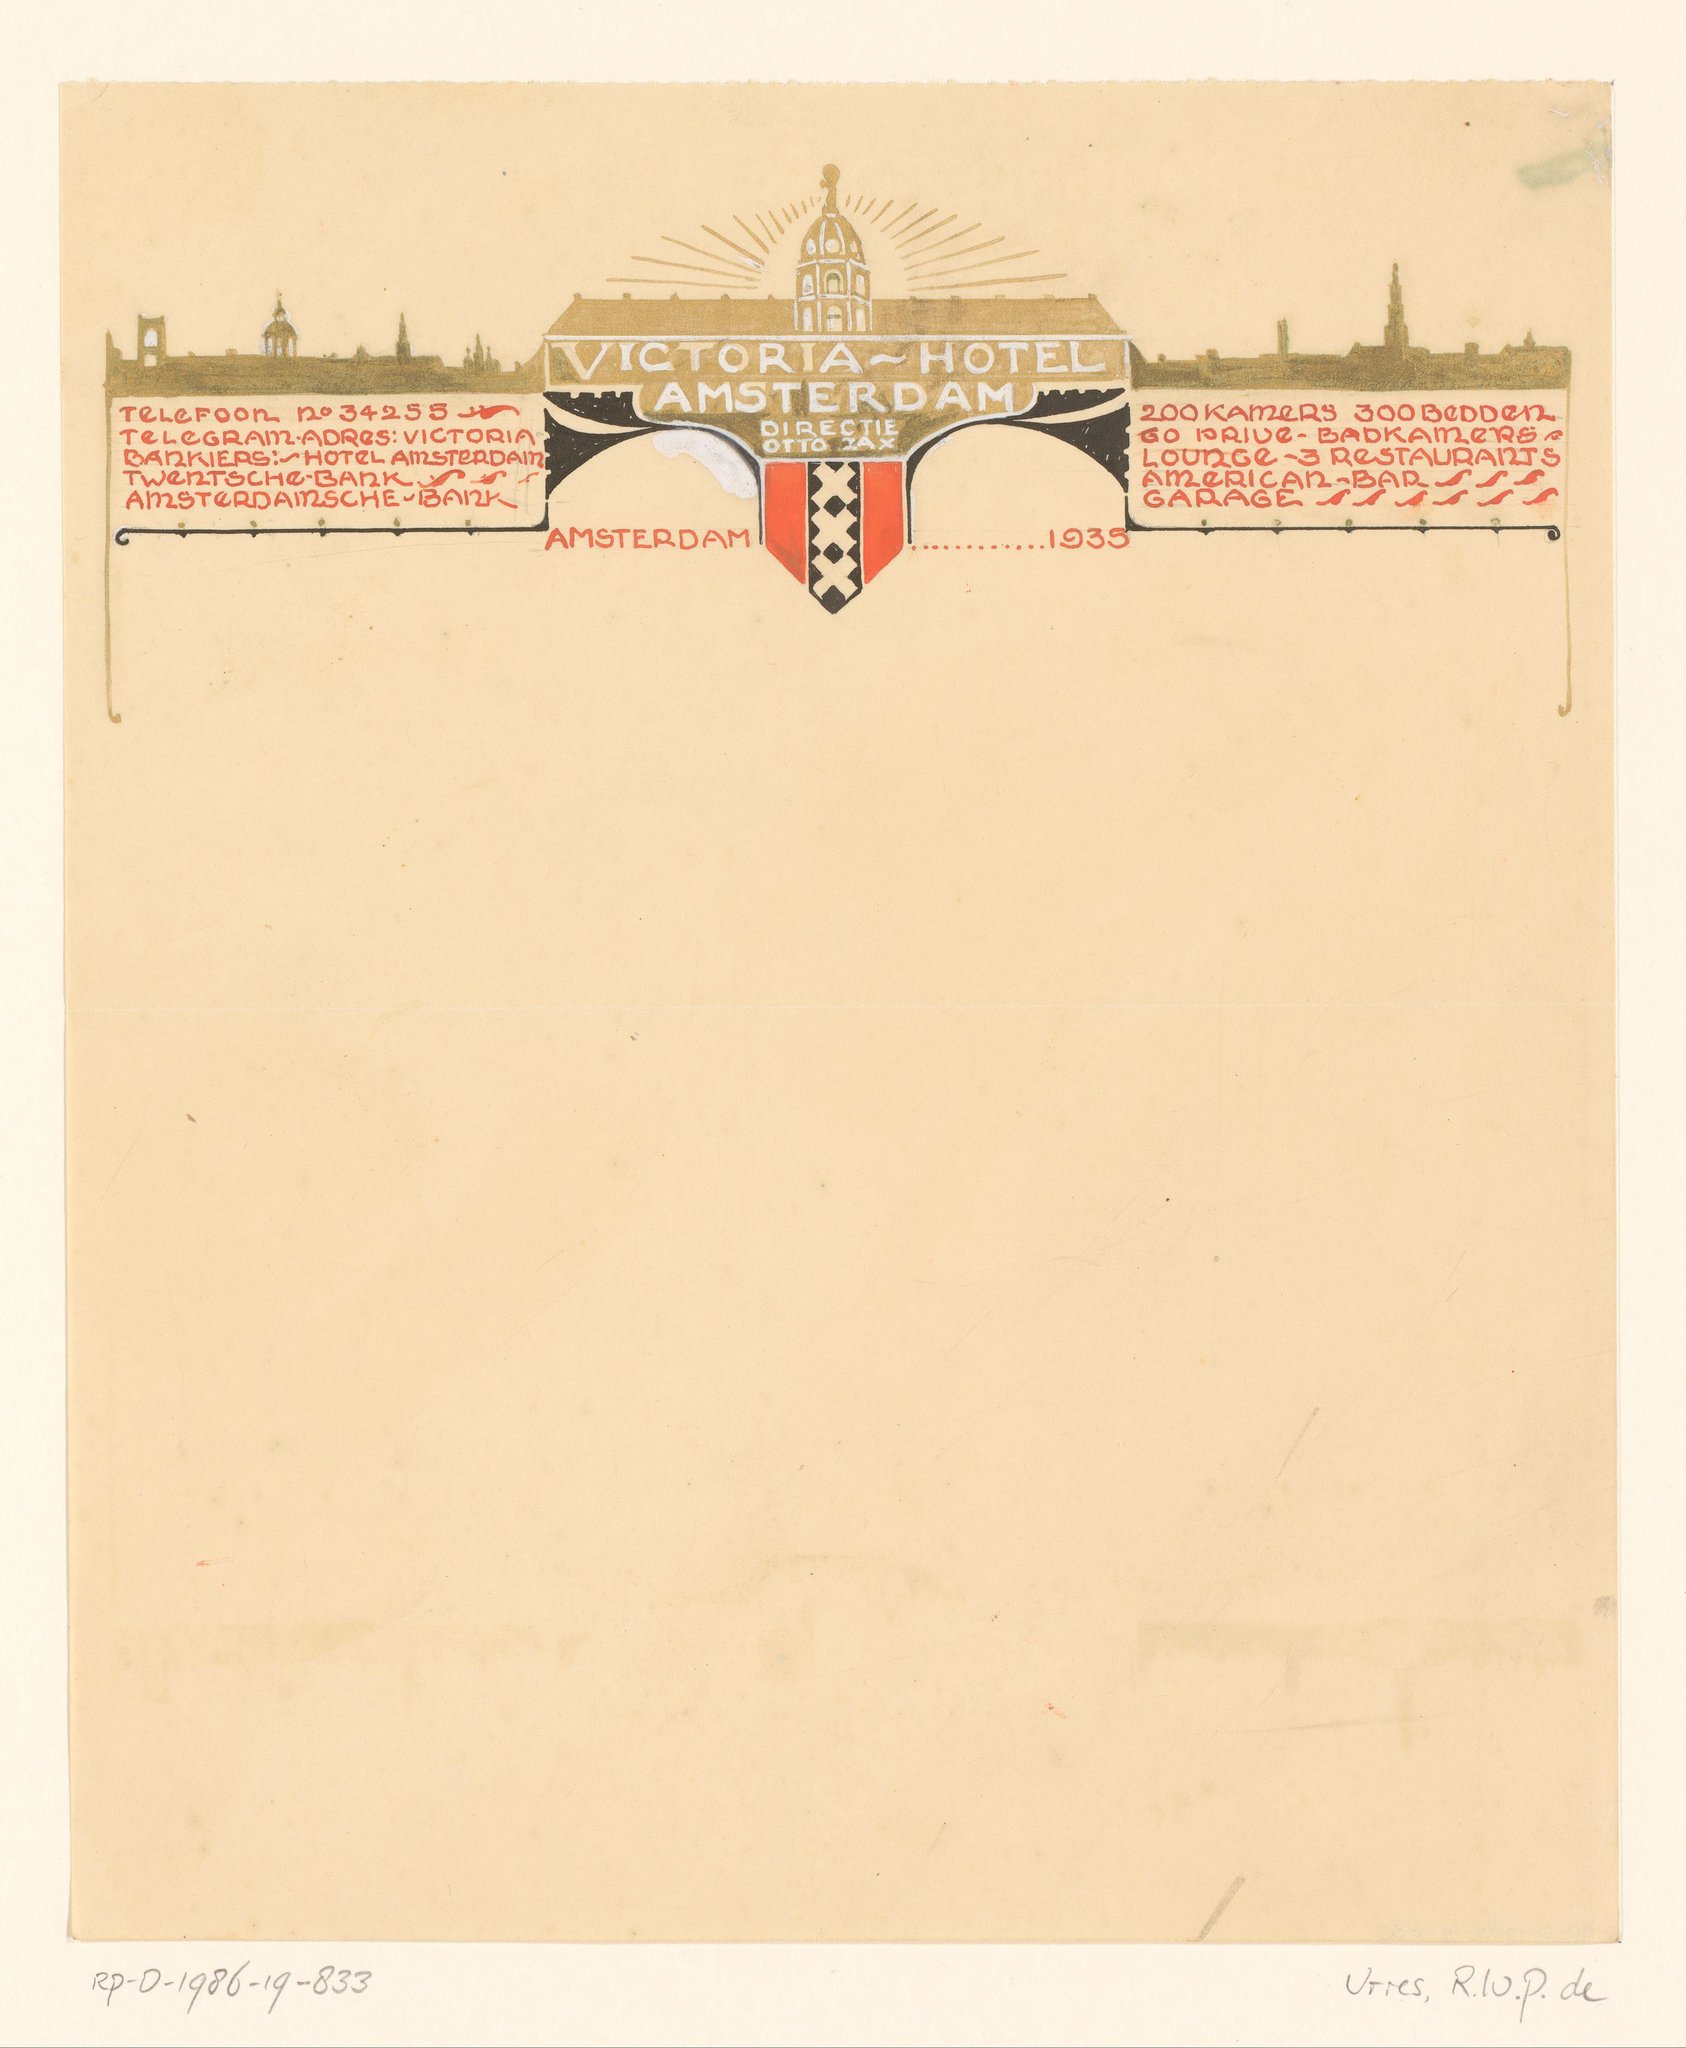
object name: design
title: Ontwerp voor een briefhoofd voor het Victoria Hotel in Amsterdam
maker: reinier willem petrus de vries (1874-1953)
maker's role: draughtsman, print maker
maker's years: 1874-1953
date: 1935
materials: paint, ink, paper, pencil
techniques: brush, pen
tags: city-view, and landscape with man-made constructions, dome ~ architecture, amsterdam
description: Ontwerp met een gezicht op Amsterdam met centraal de koepel van het Victoria Hotel en onderaan het wapen van Amsterdam.